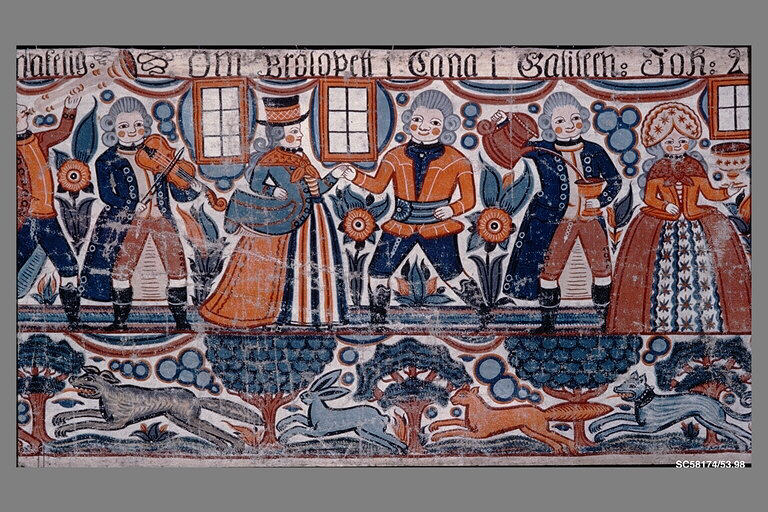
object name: wall hanging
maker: anders pålsson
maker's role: artist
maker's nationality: swedish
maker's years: 1781-1849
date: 1818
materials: linen, paint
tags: animals,men,women,violins